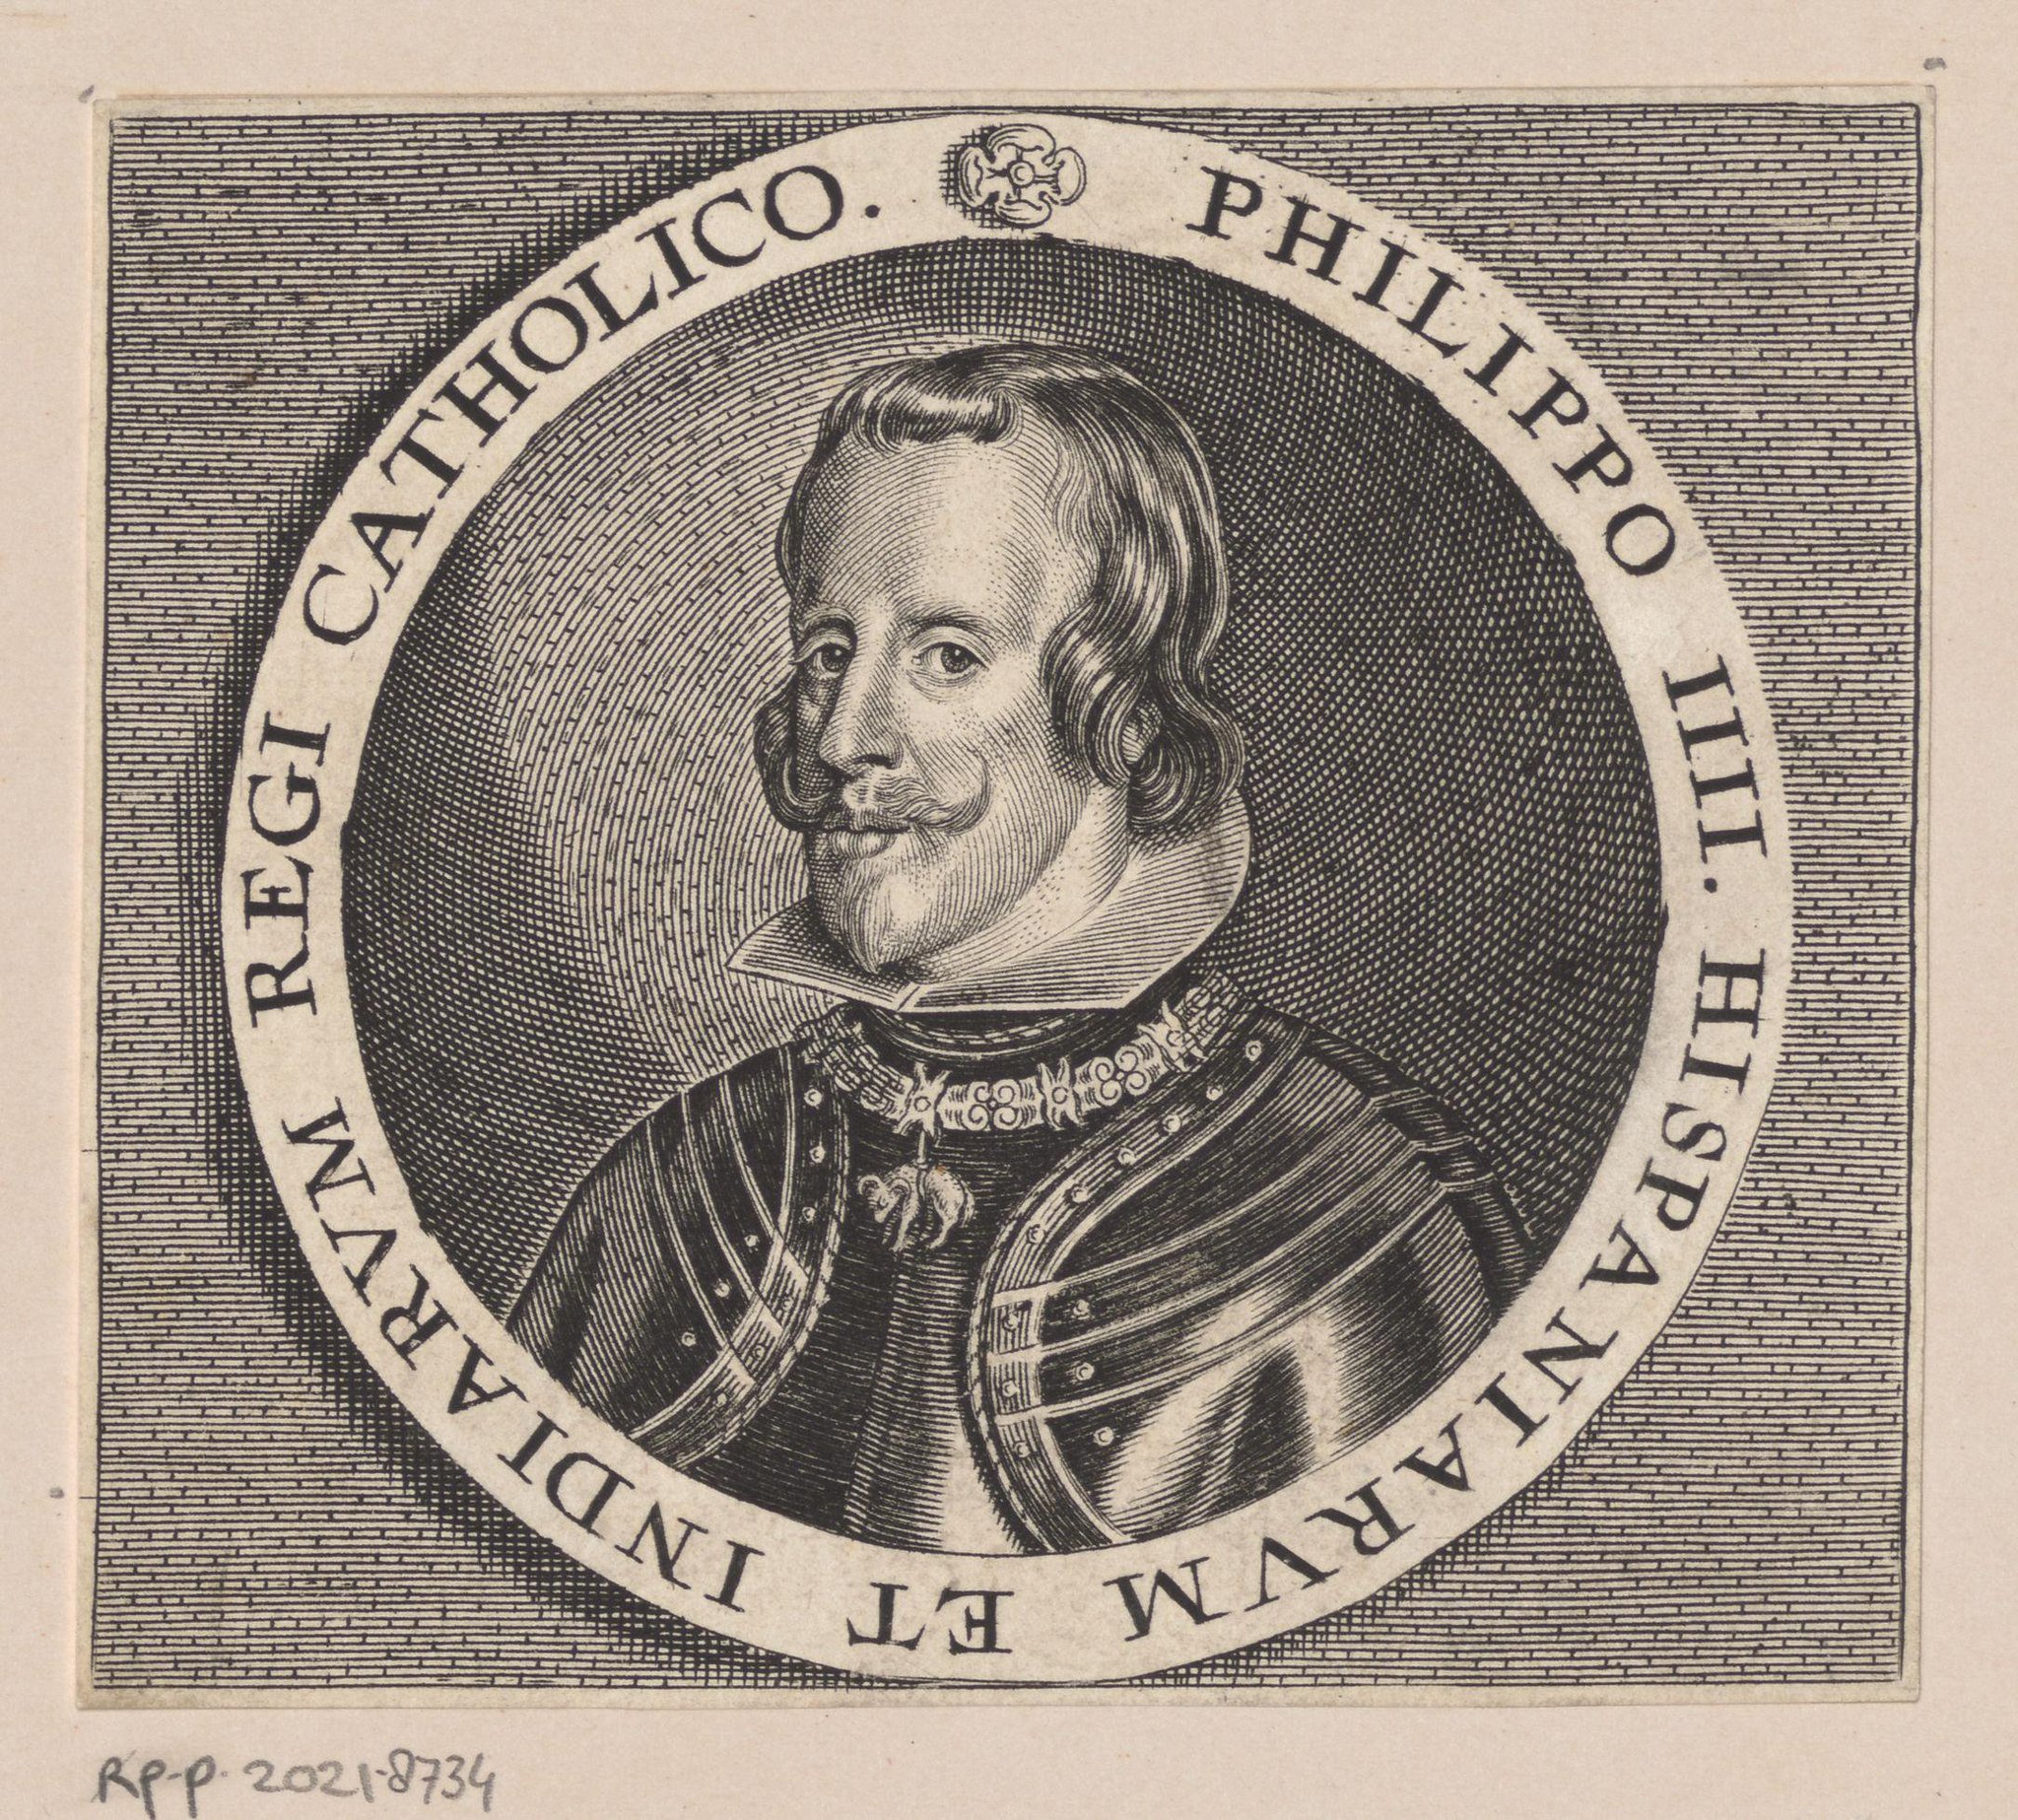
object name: print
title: Portret van Filips IV, koning van Spanje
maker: Anonymous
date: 1650-1749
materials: paper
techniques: engraving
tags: filips iv (koning van spanje), adult man, historical persons, knighthood order of the golden fleece